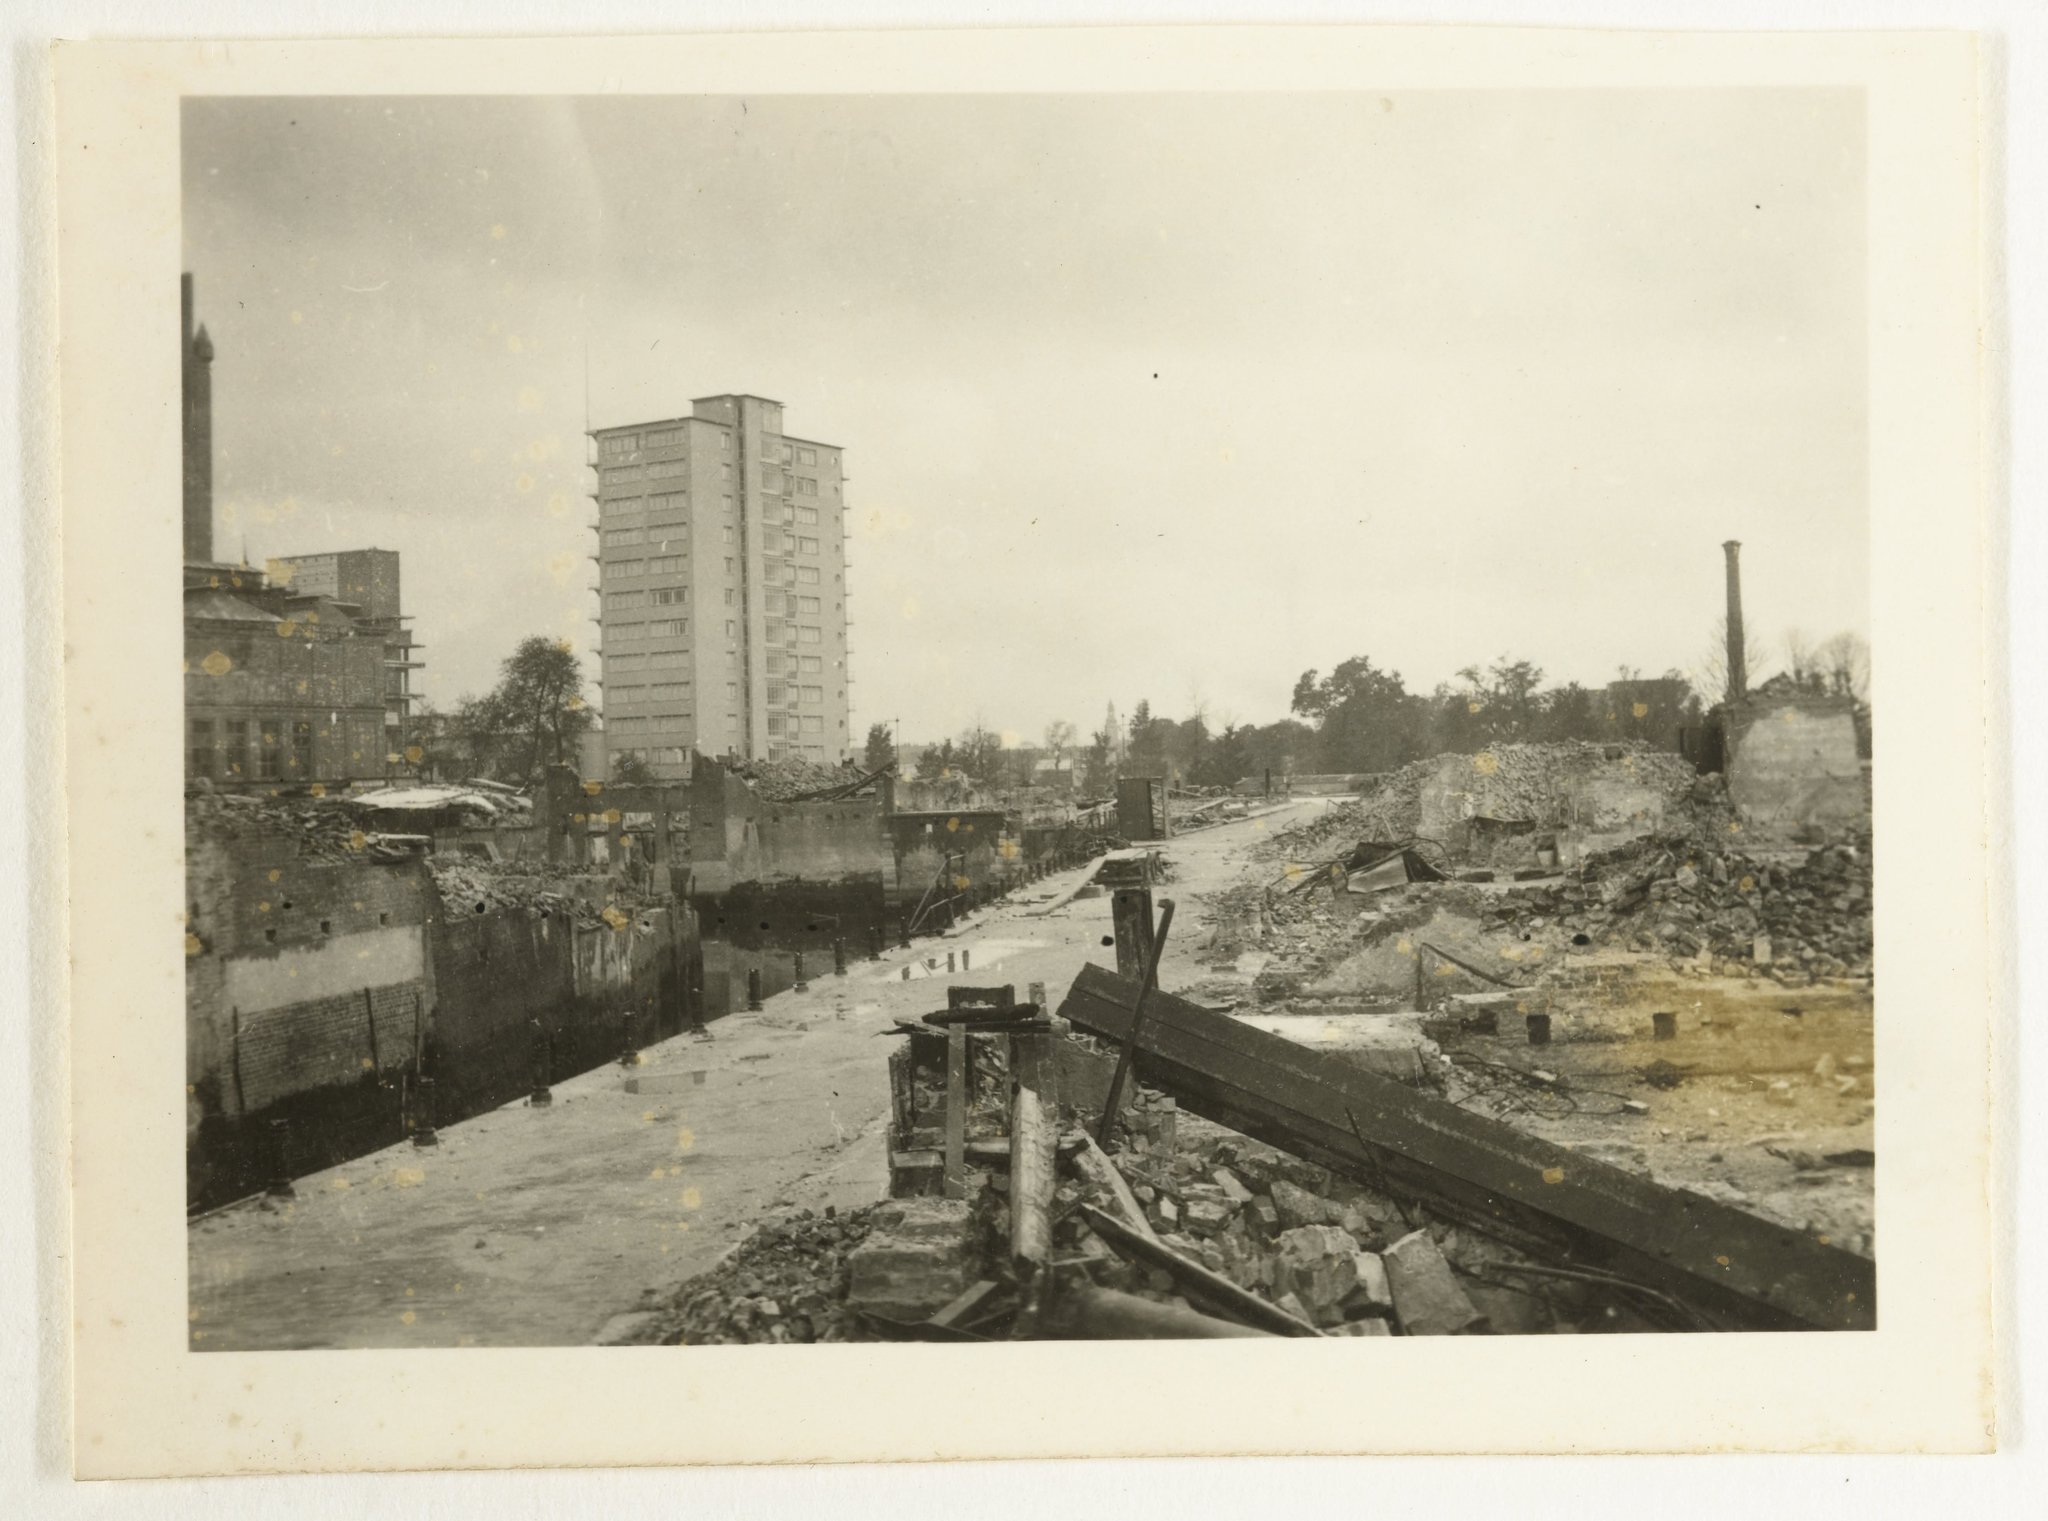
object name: photograph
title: Gebombardeerd Rotterdam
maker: Anonymous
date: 1909-1940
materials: photographic support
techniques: gelatin silver print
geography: rotterdam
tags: devastated, ruined place or city (~ warfare), rotterdam, rotterdam blitz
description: Rotterdam enige maanden na het bombardement. Links staat nog een vrijwel onbeschadigd flatgebouw. Op achterzijde staat: Rotterdam im Sept. 1940